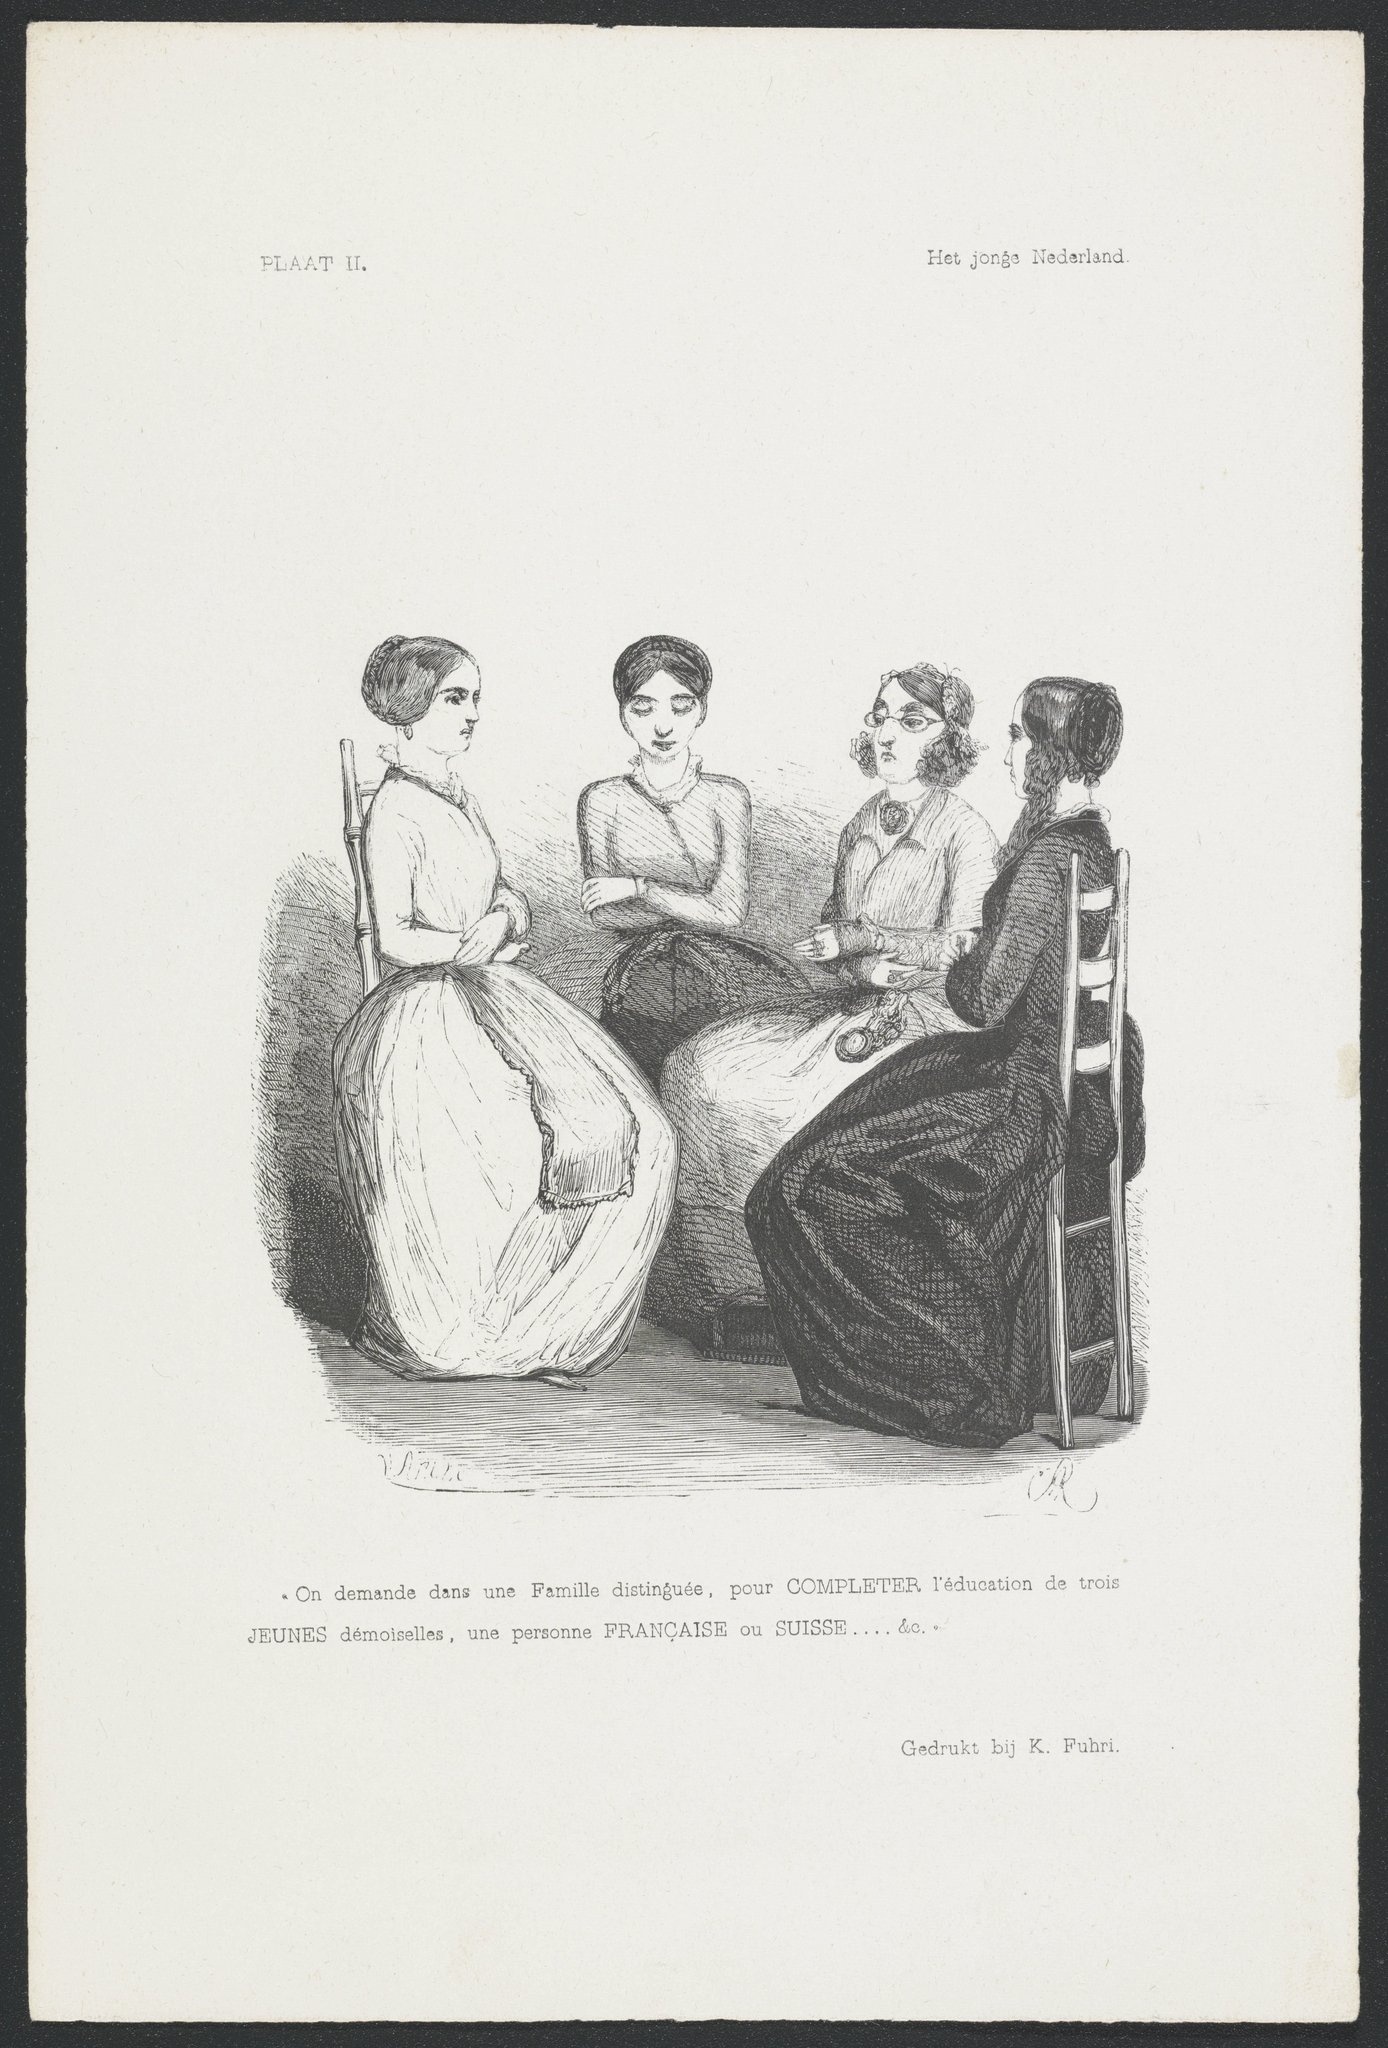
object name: print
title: Vier vrouwen bespreken de keuze tussen een Zwitserse en een Franse gouvernante voor drie meisjes uit een voorname familie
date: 1847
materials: paper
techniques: letterpress printing, engraving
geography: amsterdam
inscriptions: collector's mark: Lugt 2228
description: Vier vrouwen zitten in een kring. In de ondermarge twee regels Franse tekst in boekdruk.